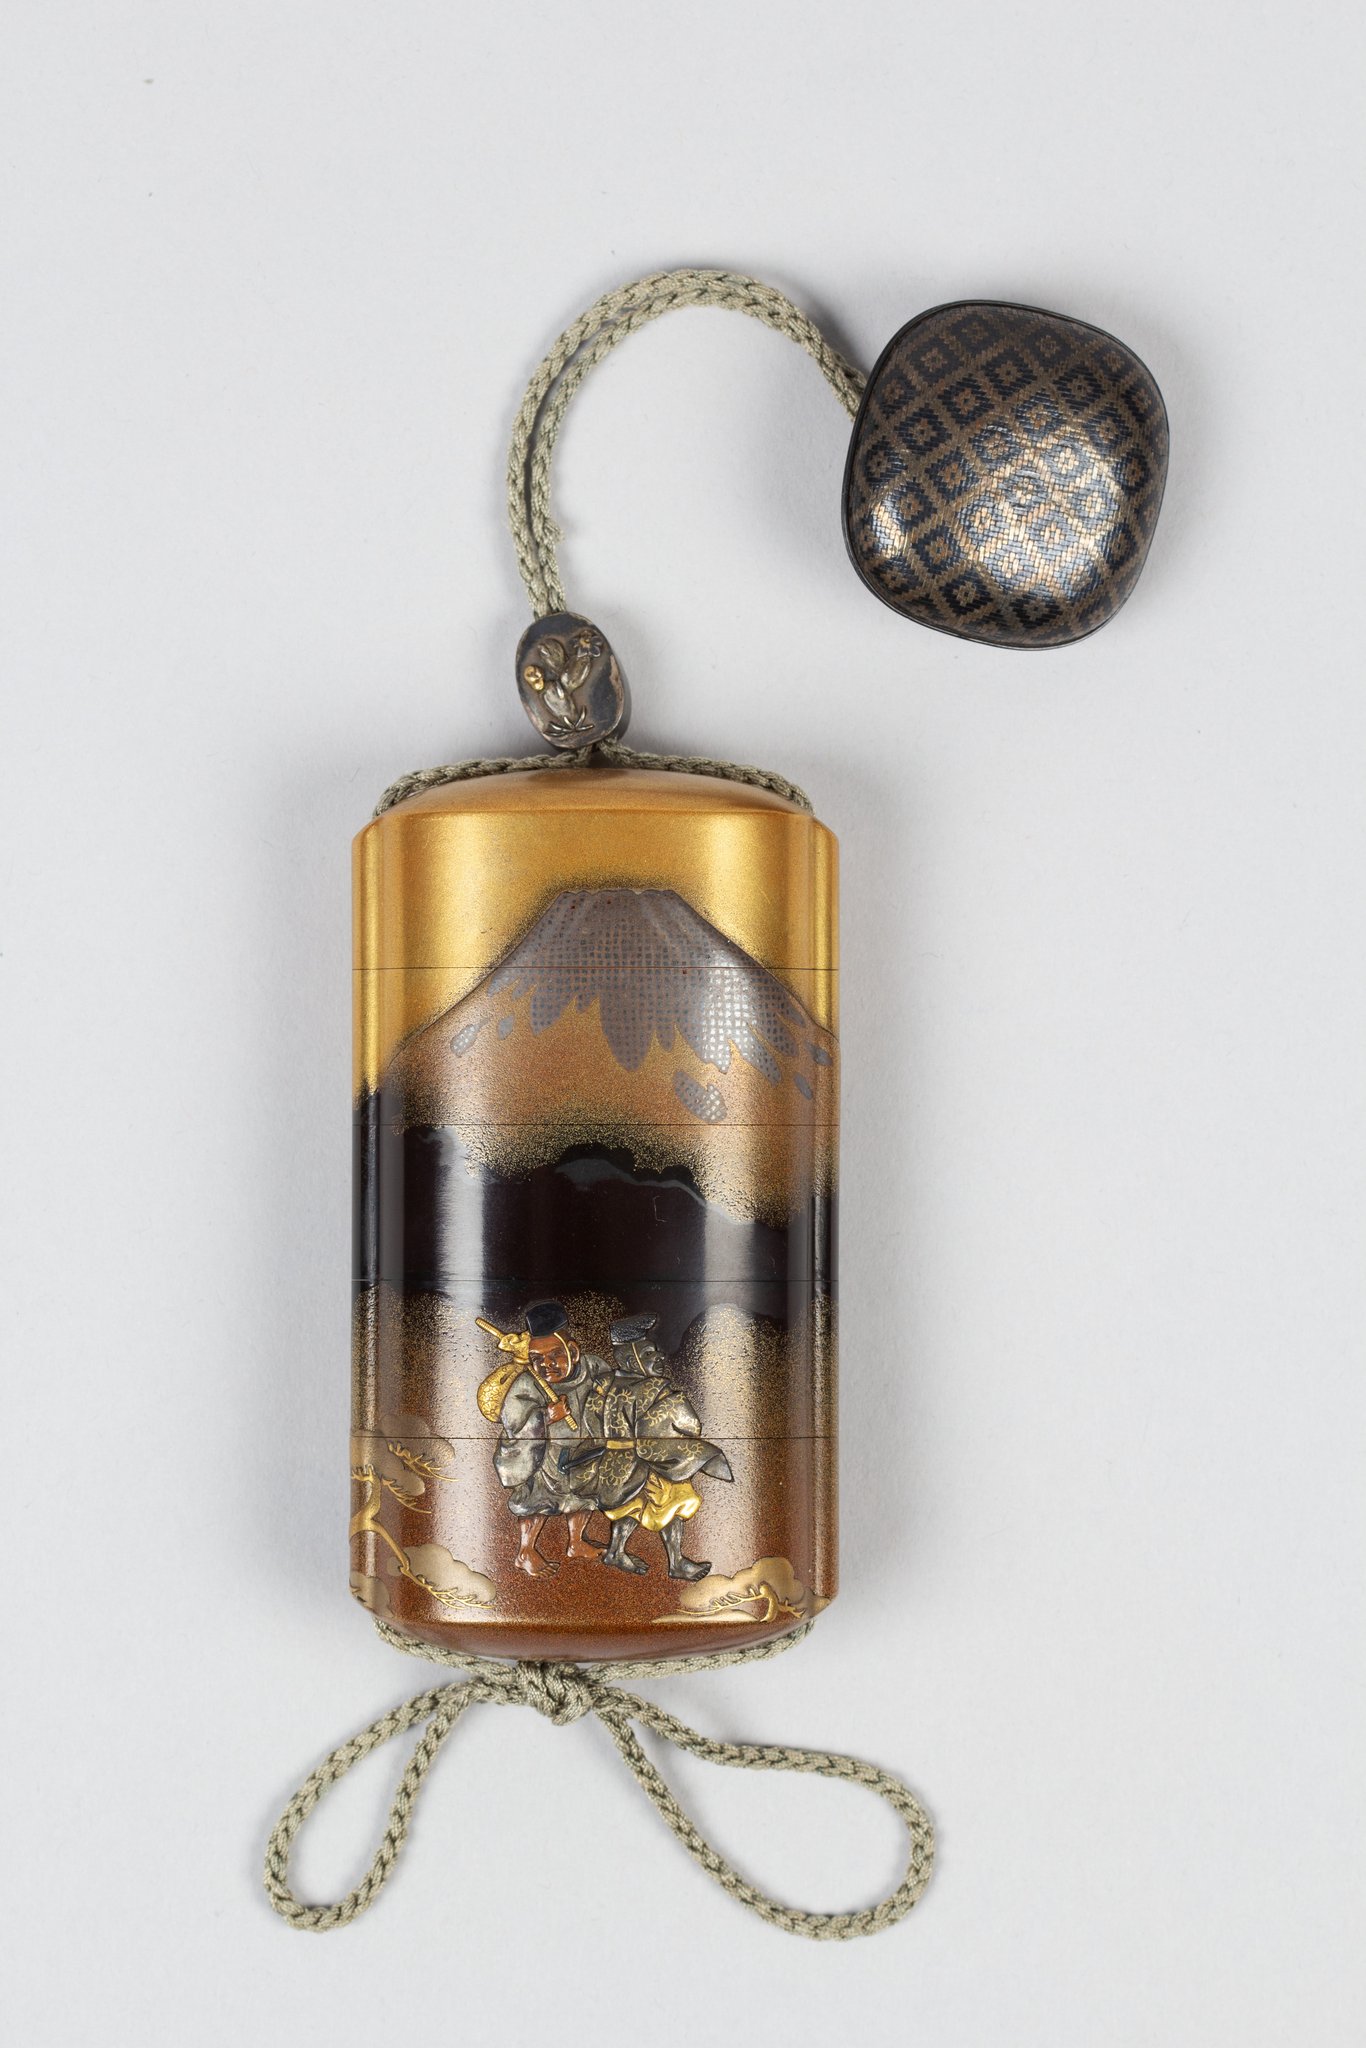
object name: inrō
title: Case (Inrō) with Design of Narihira at Mount Fuji, from The Tales of Ise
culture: japanese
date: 1801-1900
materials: gold, lacquer, metal, silver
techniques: fundame, hiramakie, inlay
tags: men,horses,mountains